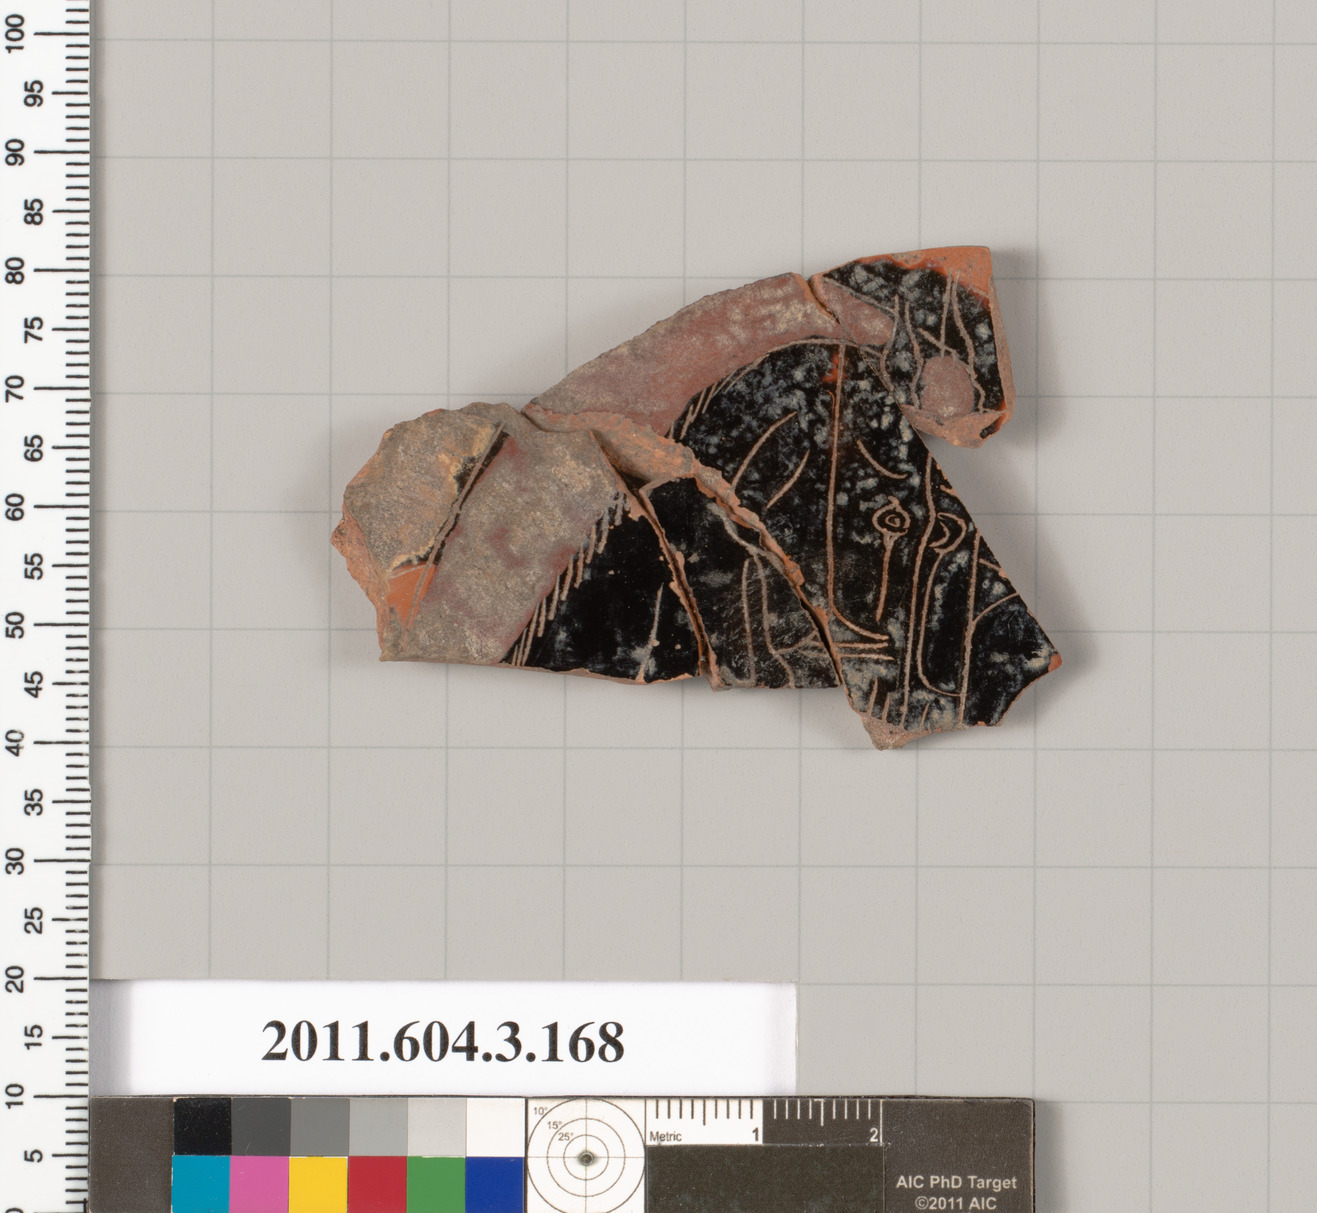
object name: amphora fragment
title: Terracotta fragment of an amphora (jar)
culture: greek, attic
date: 530-520 BCE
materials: terracotta